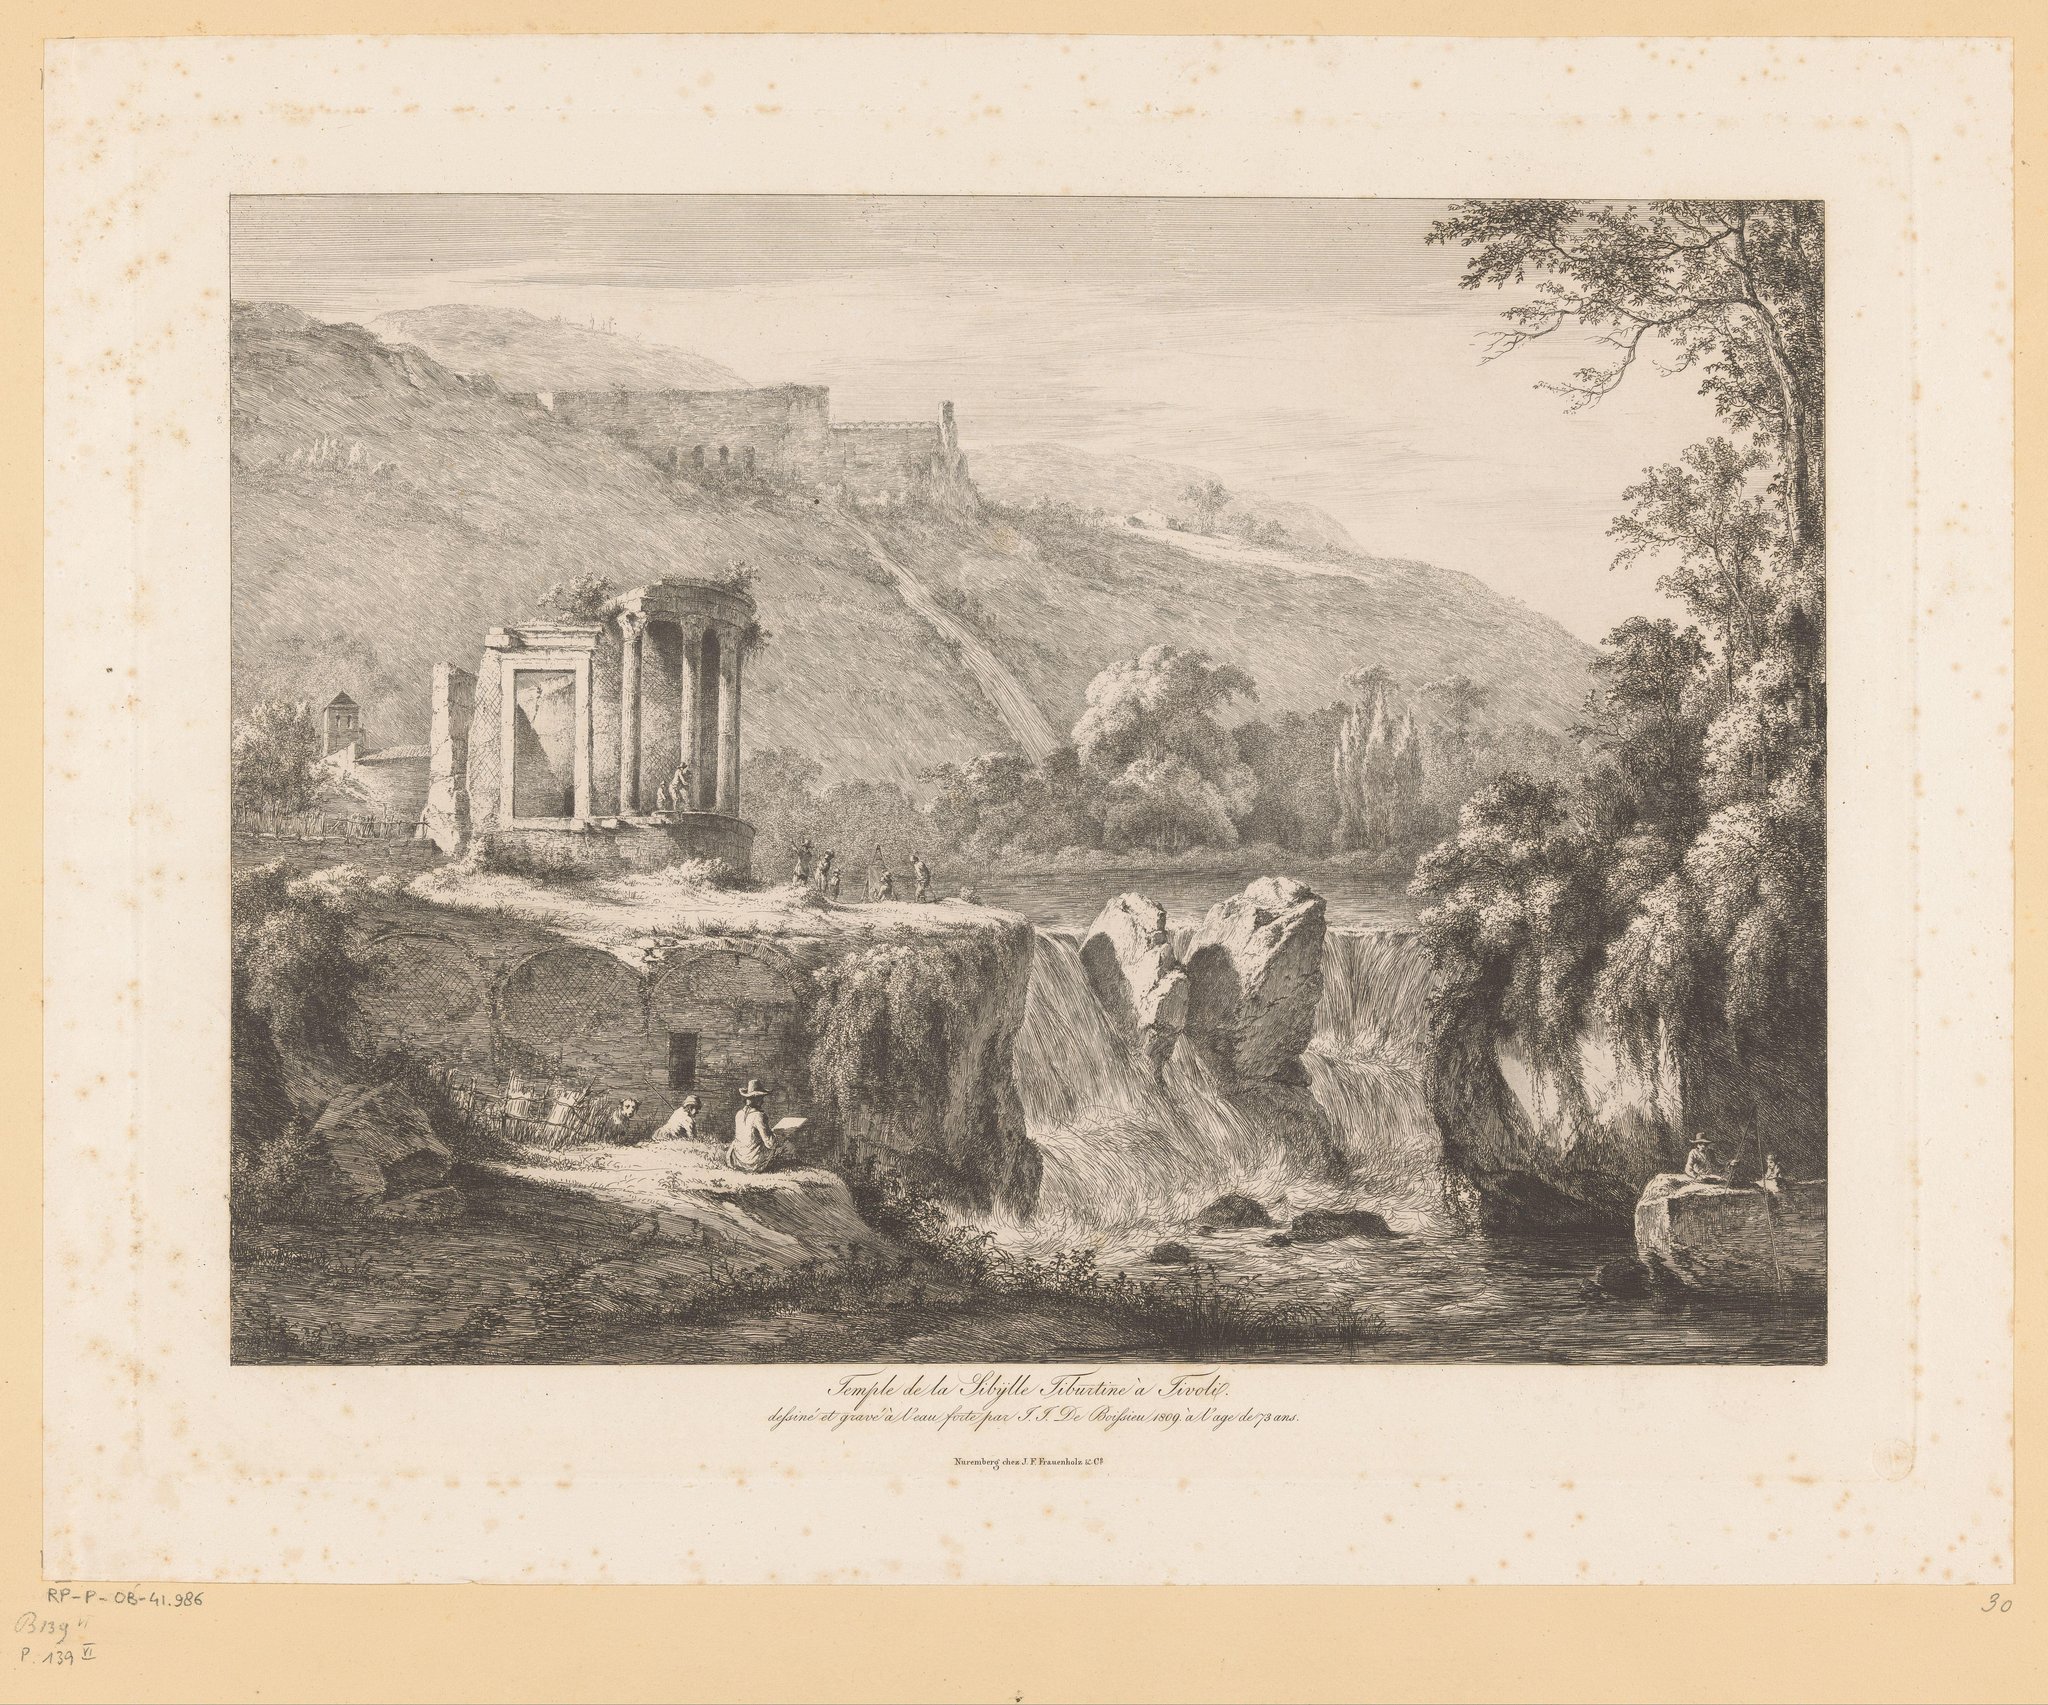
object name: print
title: Gezicht op de tempel van Vesta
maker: jean jacques de boissieu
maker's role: draughtsman, print maker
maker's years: 1736-1810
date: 1809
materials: paper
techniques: drypoint, etching, roulette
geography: france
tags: ruin of a building ~ architecture, landscape with ruins, temple, shrine ~ roman religion, tivoli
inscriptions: collector's mark: Lugt 12, collector's mark: Lugt 994